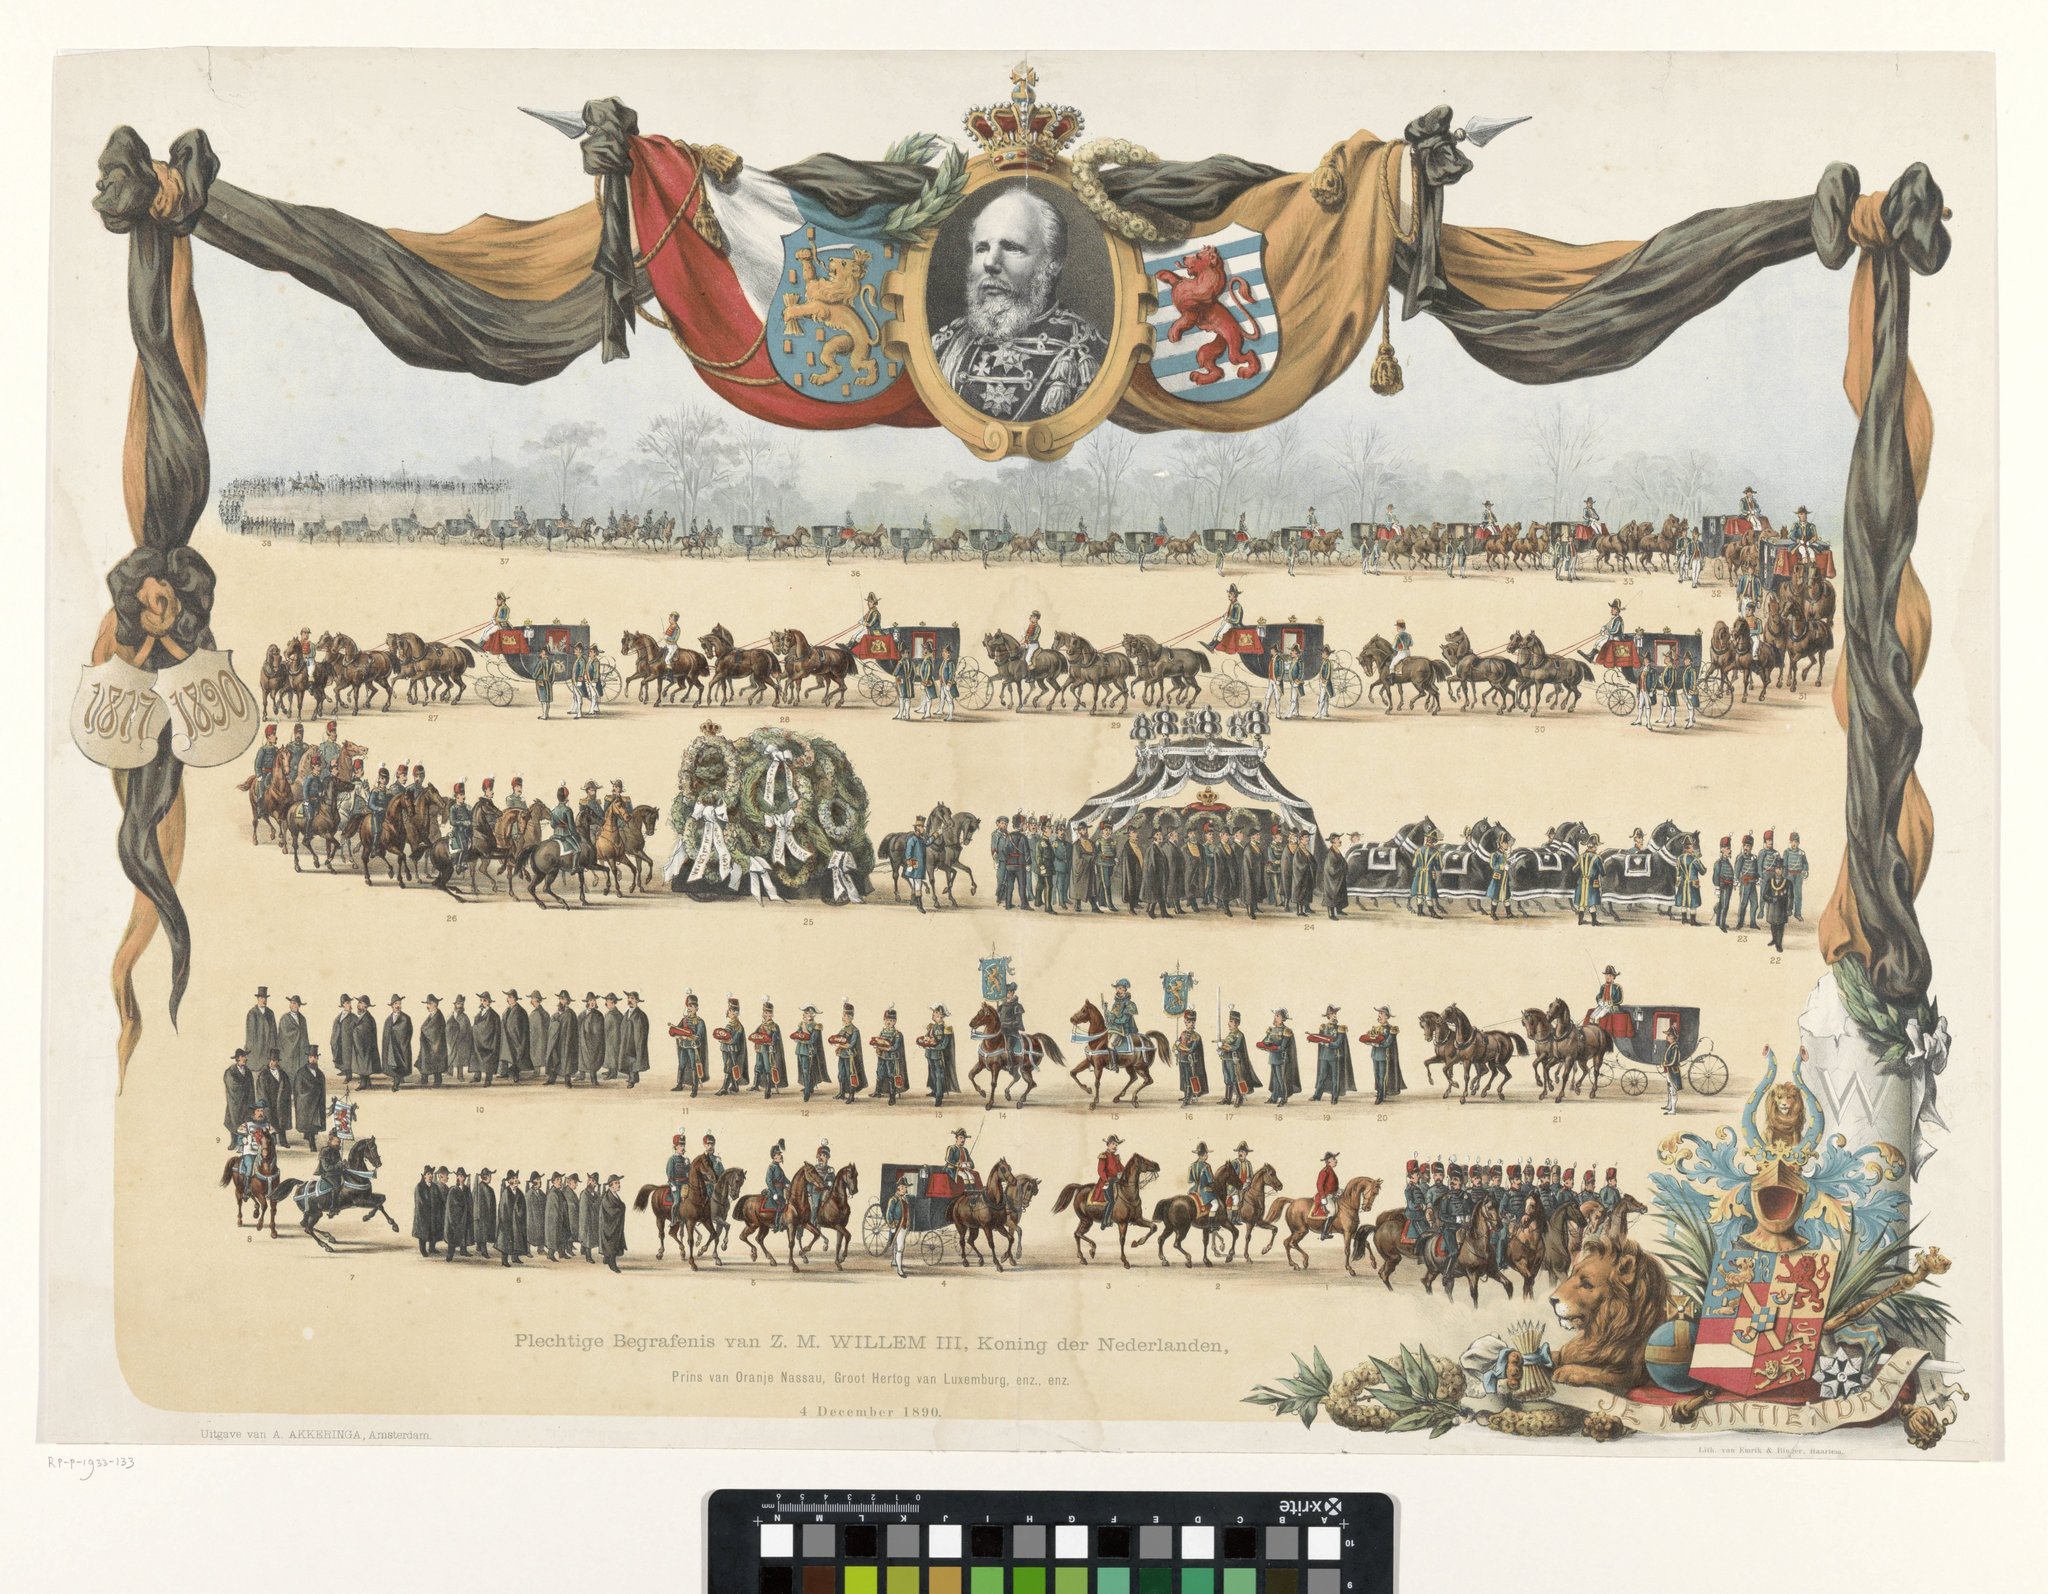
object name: print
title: Plechtige Begrafenis van Z.M. Willem III, Koning der Nederlanden (...) 4 December 1890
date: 1890-1891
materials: paper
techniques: lithograph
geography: netherlands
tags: brussels, willem iii (koning der nederlanden), cortege, funeral procession, delft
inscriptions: collector's mark: Lugt 2228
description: Begrafenis van Koning Willem III op 4 december 1890 te Delft. De stoet afgebeeld in vijf rijen onder elkaar binnen een omlijsting van oranjedoeken en rouwdoeken. Linksonder de Nederlandse Leeuw bij het familiewapen van de koning. Bovenaan een portret van de overleden koning.